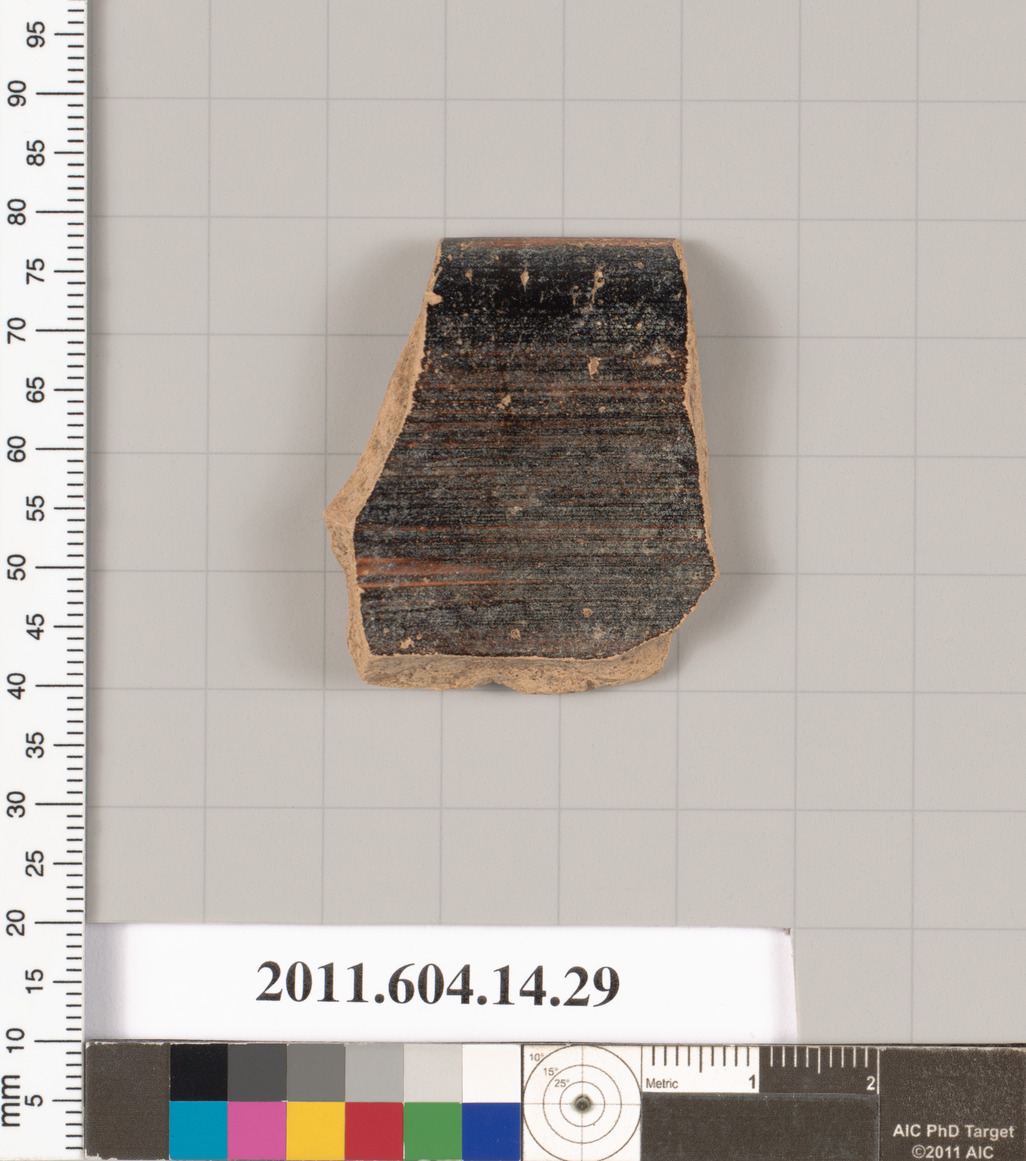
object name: skyphos fragment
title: Terracotta fragment of a skyphos (deep drinking cup)?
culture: unknown fabric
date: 600-401 BCE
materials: terracotta